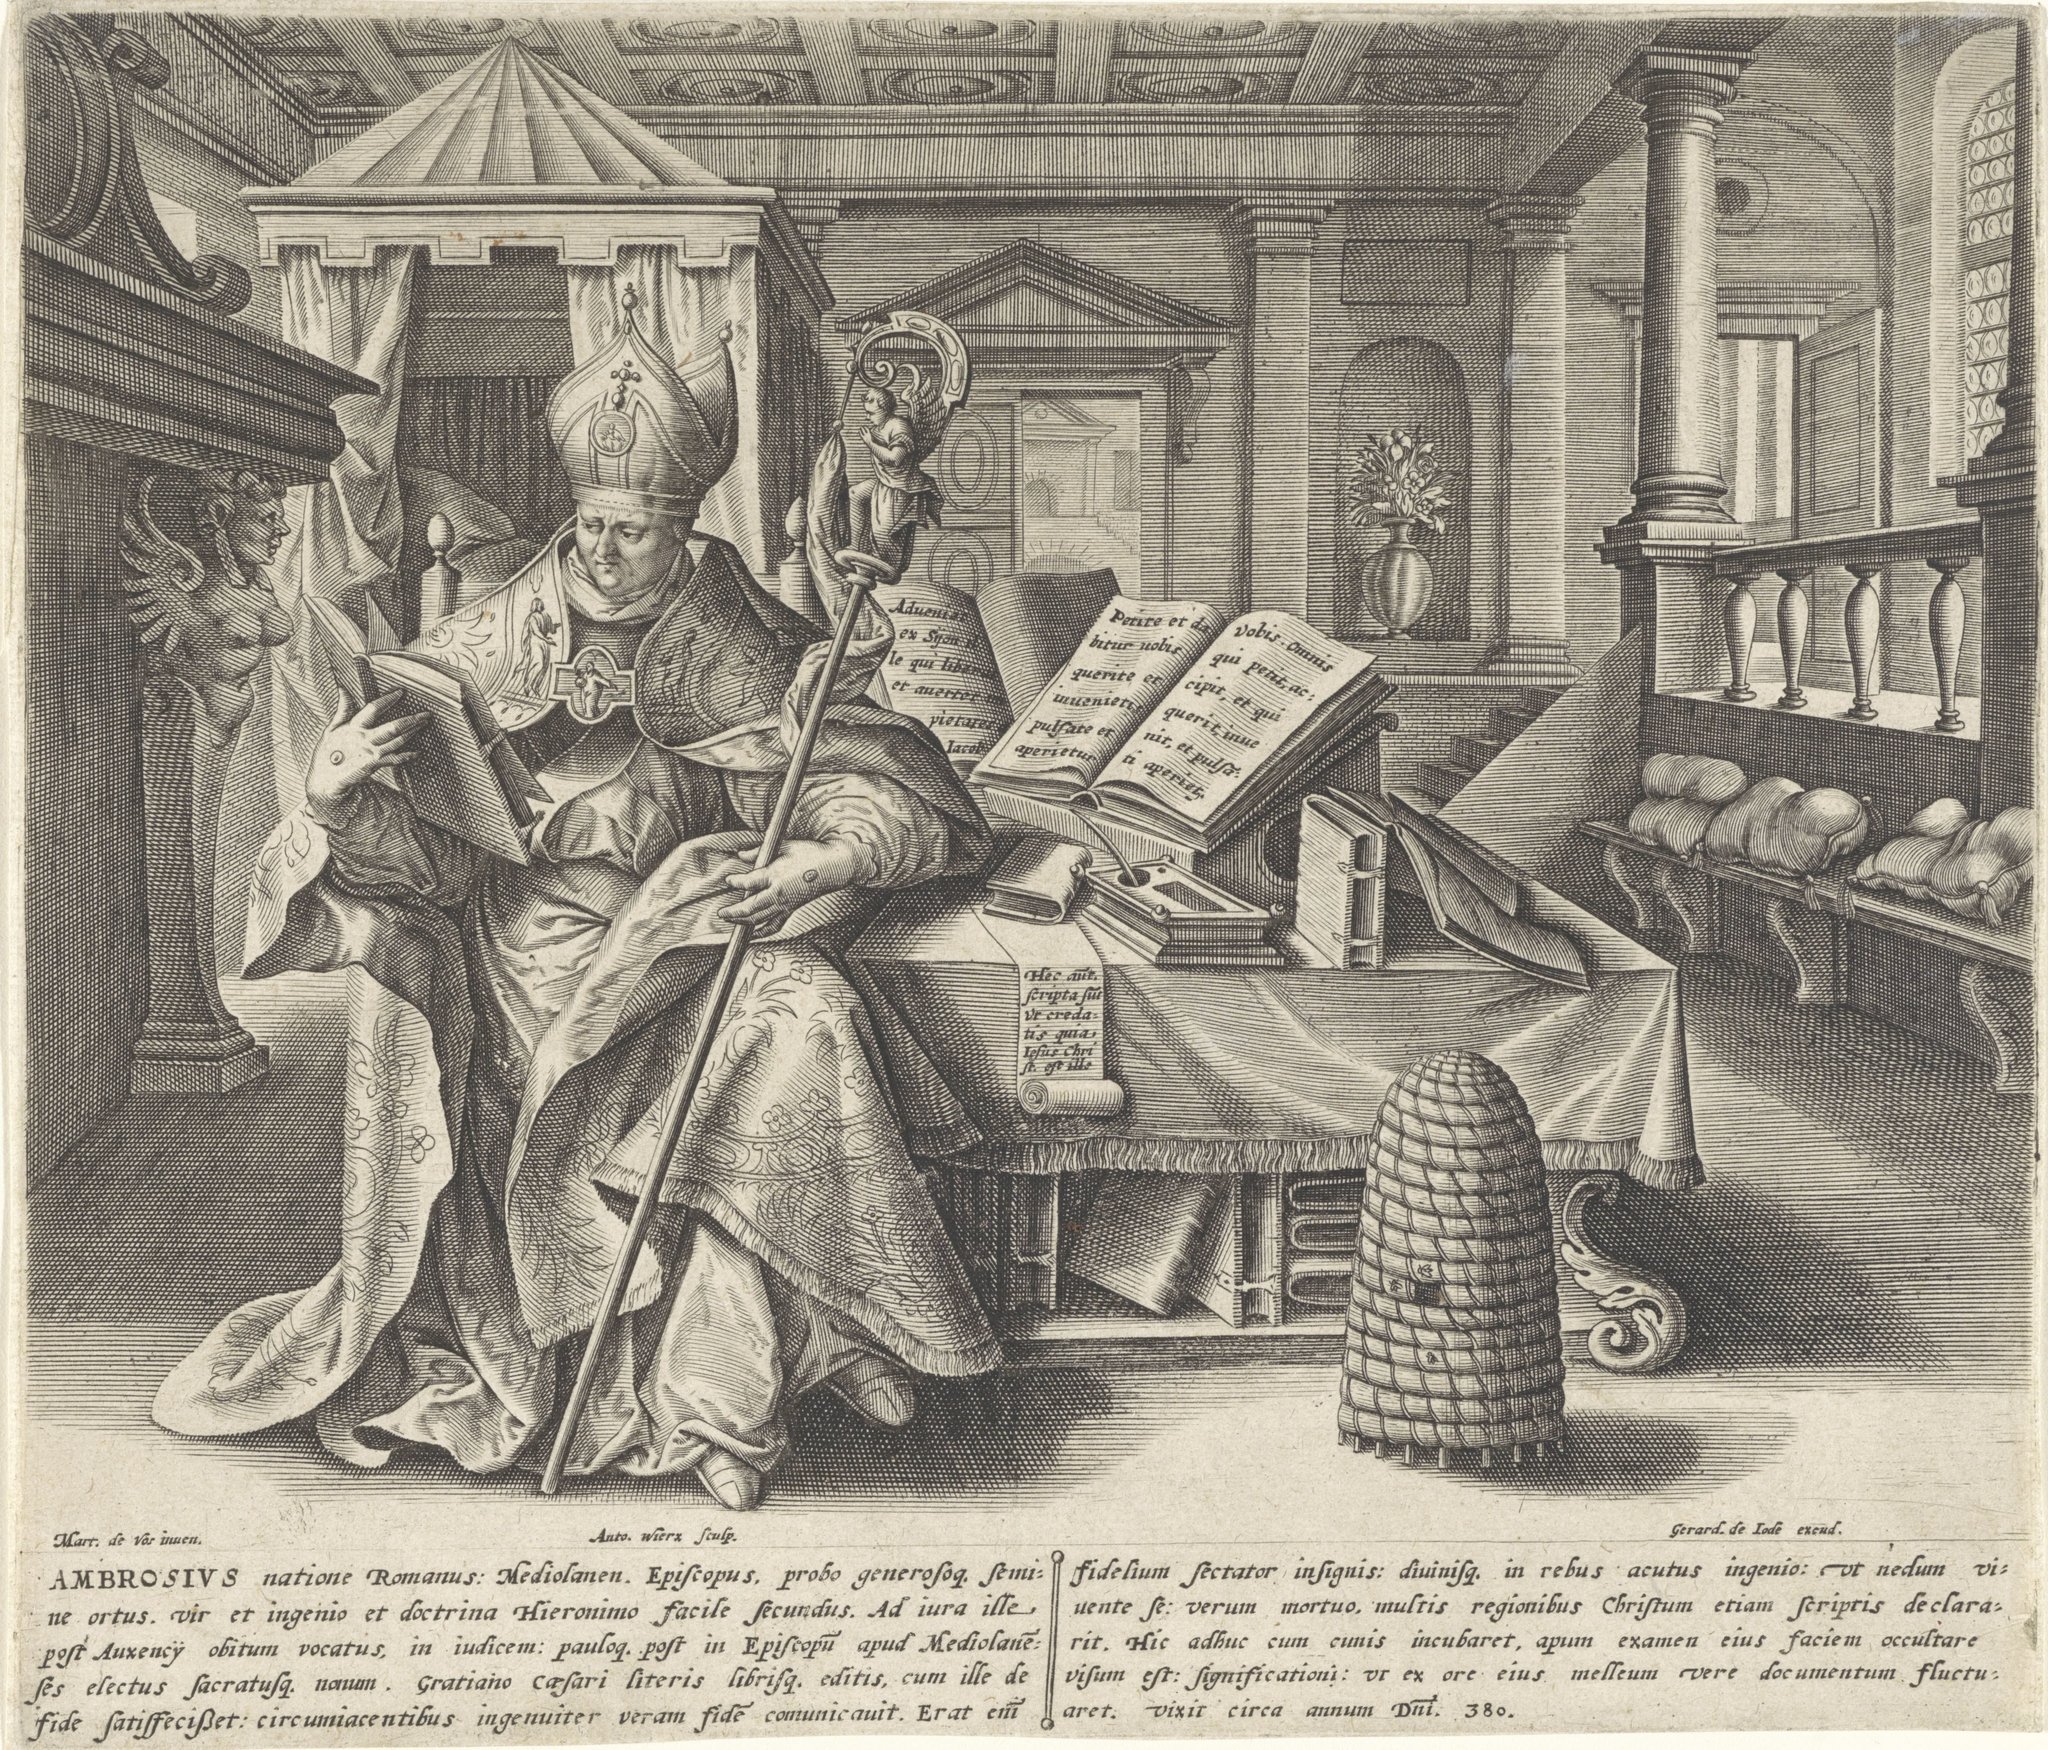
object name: print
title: Thesaurus sacrarum historiarum veteris testamenti (...)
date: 1585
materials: paper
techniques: engraving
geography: antwerp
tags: the four latin (western) fathers of the church together: ambrose (usually as bishop), jerome (usually as cardinal), augustine (usually as bishop), gregory the great (usually as pope), st. ambrose as doctor of the latin church in his study at his writing desk with book, pen and sometimes a dove (divine inspiration)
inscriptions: collector's mark: Lugt 2228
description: De H. Ambrosius zit in zijn studeervertrek aan een tafel vol met boeken. Hij draagt zijn bisschopsmantel. In zijn handen houdt hij zijn staf en een opengeslagen boek. Op de voorgrond staat de bijenkorf, een verwijzing naar de zwerm bijen die in zijn mond ging zitten toen hij in de wieg lag. In de marge een tienregelig onderschrift, in twee kolommen, in het Latijn.